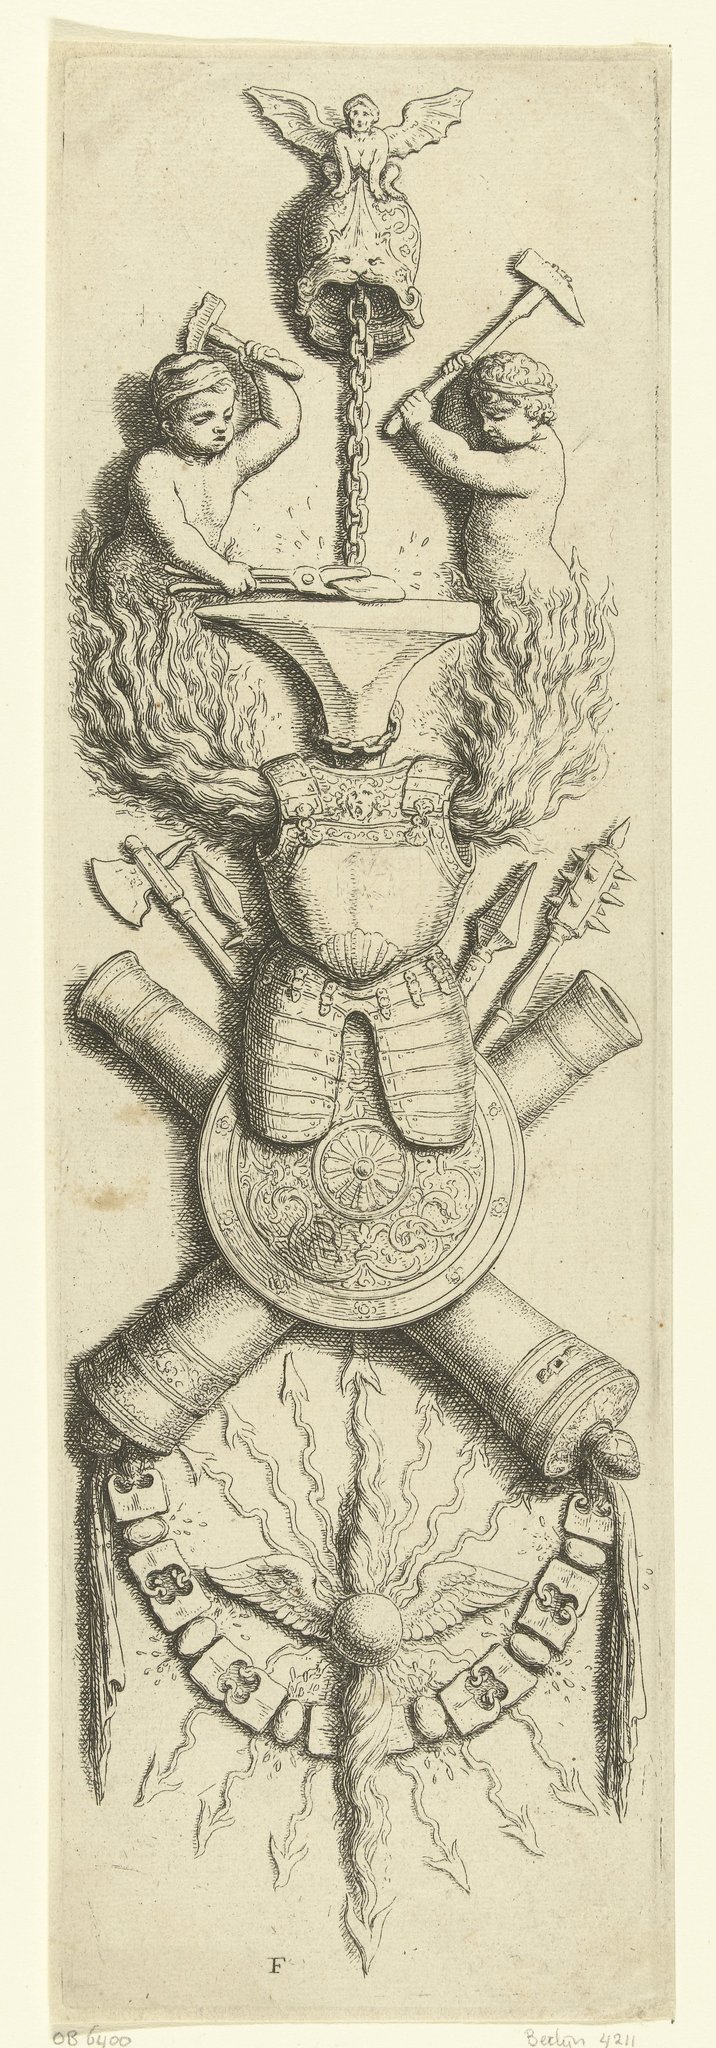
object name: ornament print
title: Secunda Pars Praecipuarum (...)/Het Tweede Deel Van de voornaemste Statuen ende Cieraten (...)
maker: hubert quellinus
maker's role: print maker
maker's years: 1619-1687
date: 1663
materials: paper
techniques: etching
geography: amsterdam